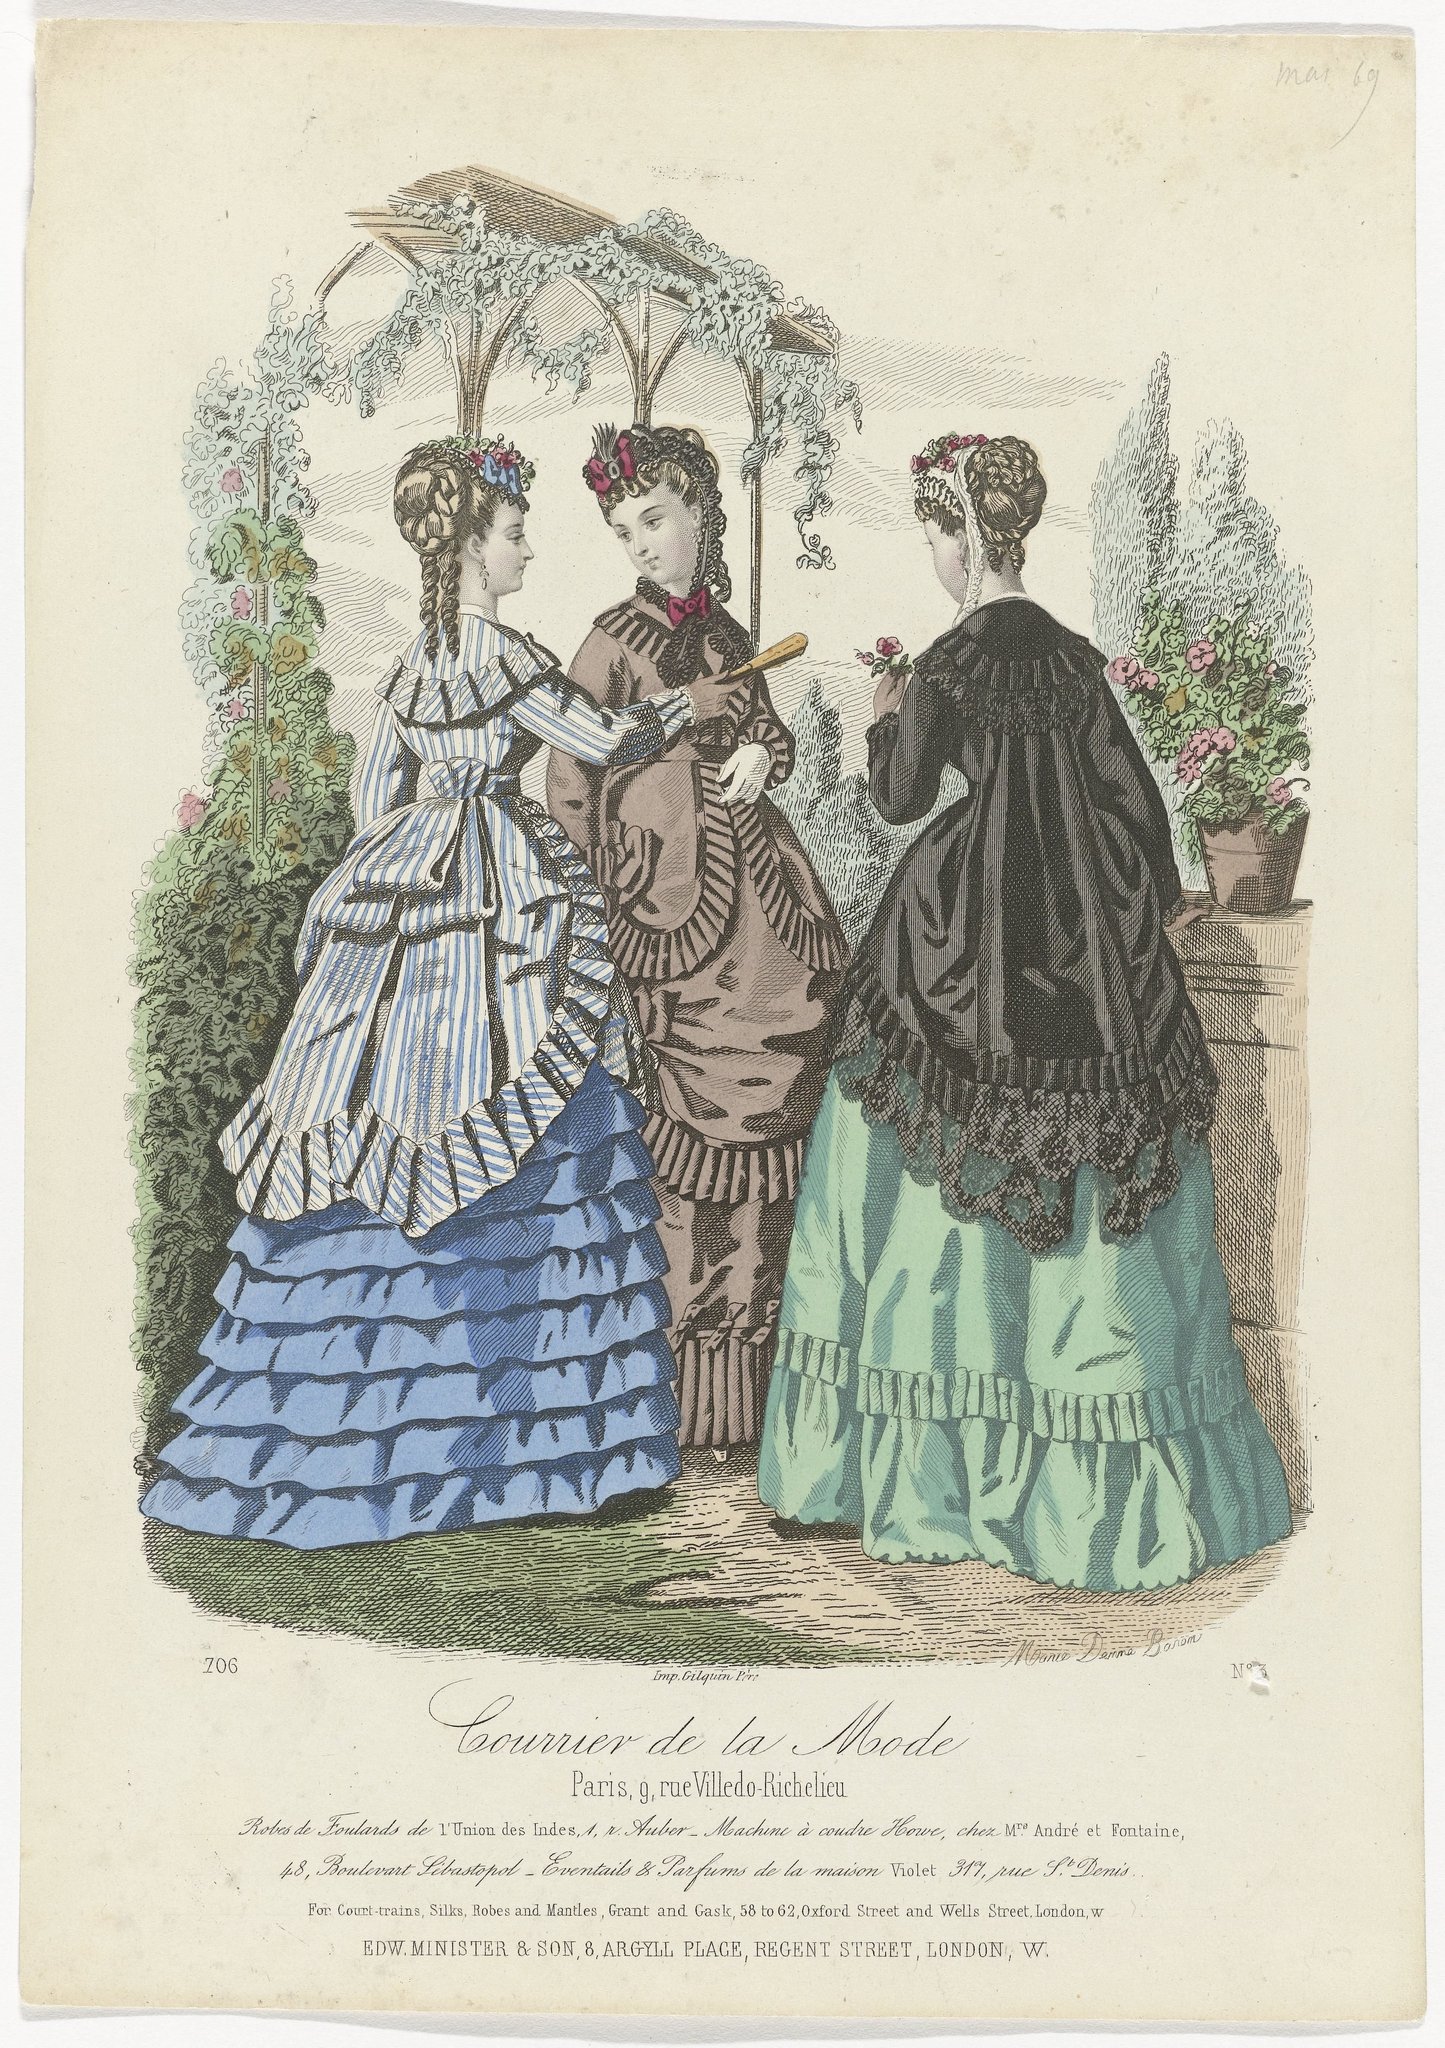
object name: fashion print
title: Courrier de la Mode, ca. 1870, No. 706, No. 3 : Robes de Foulards (...)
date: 1870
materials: paper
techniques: engraving, hand coloring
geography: paris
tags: cut flowers; nosegay, bunch of flowers, head-gear (+ women's clothes), fashion plates, skirt (+ women's clothes), gloves, mittens, etc. (+ women's clothes), dress, gown (+ women's clothes), fan (+ women's clothes)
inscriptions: caption: ‘Robes de Foulards de l'Union des Indes, 1, r. Auber _ Machine à coudres Howe, chez Mrs André et Fontaine, 48, Boulevart Sébastopol _ Eventails & Parfums de la maison Violet 317, rue St Denis.’, title: ‘Courrier de la Mode’, caption: ‘For court-trains, Silks, Robes and Mantles, Grant and Gask, 58 to 62, Oxford Street and Wells Street, London, w / Edw. Minister & Son, 8, Argyll Place, Regent Street, London, W.’, address: ‘Paris,9, rue Villedo-Richelieu’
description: Drie vrouwen staan buiten te praten. Volgens het onderschrift dragen ze 'robes de Foulards', gemaakt van stoffen van Union des Indes, met een naaimachine van Howe, bij Mrs André et Fontaine. De waaiers zijn van de firma Violet en de mantels van Grant and Gask. Prent uit het modetijdschrift Courrier de la Mode (1857-1871).